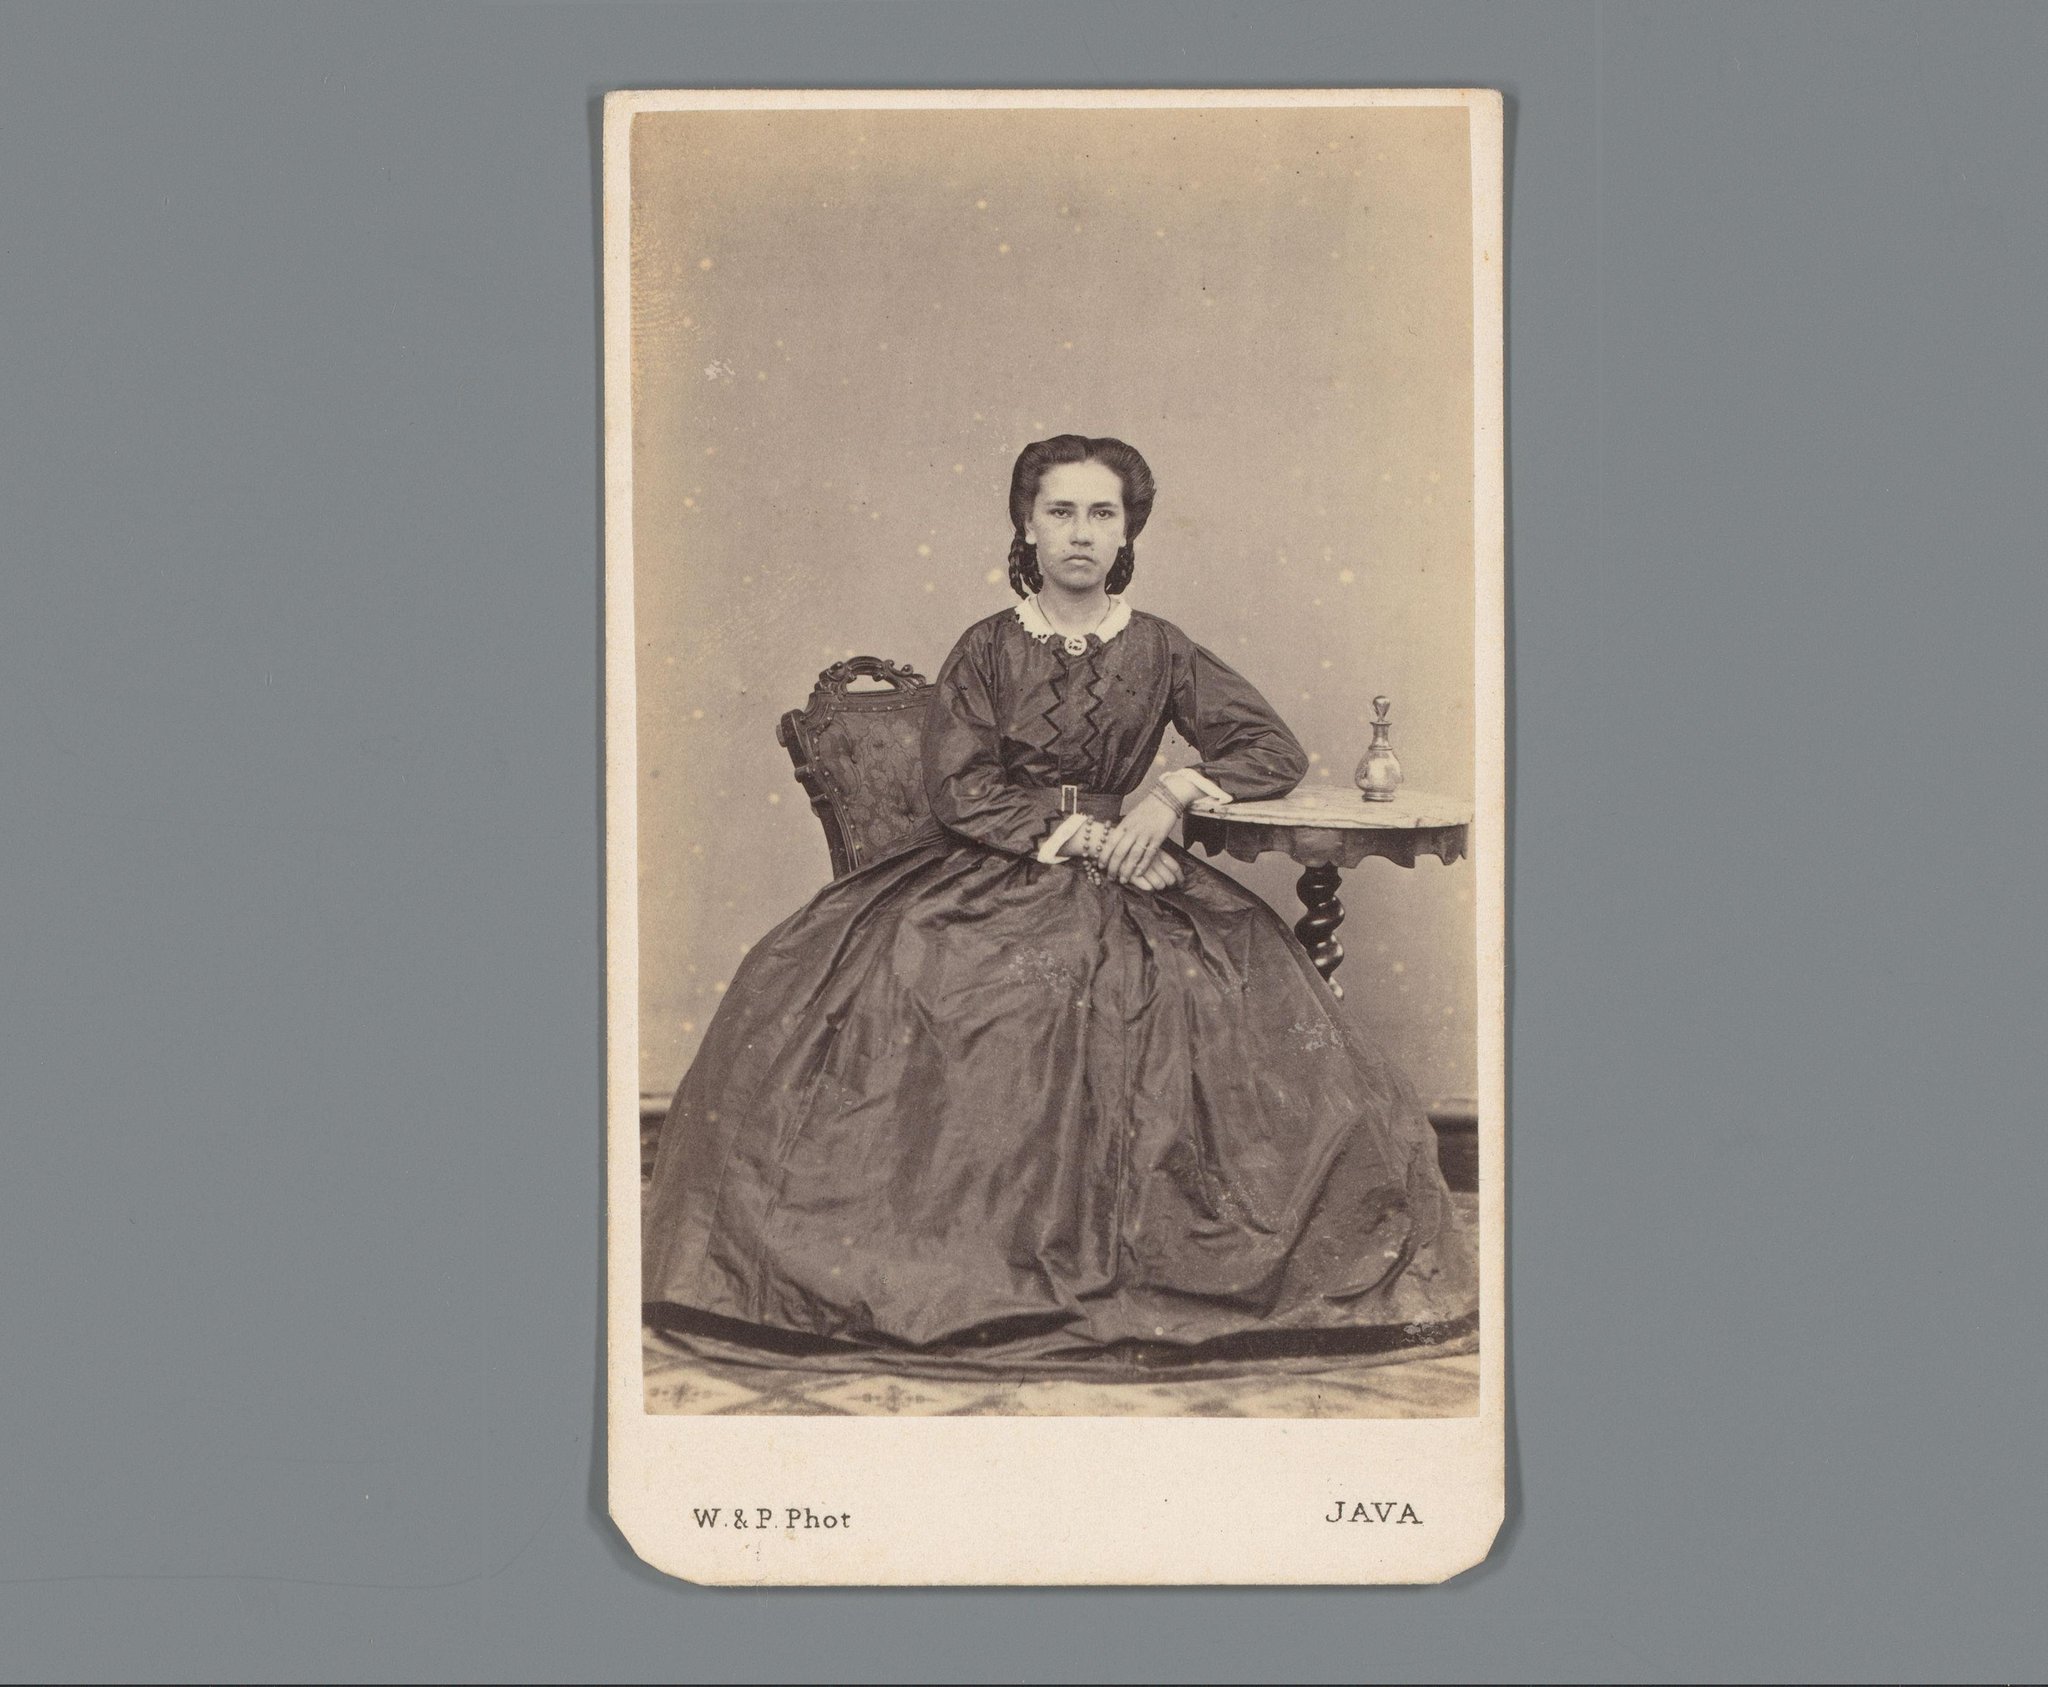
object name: carte de visite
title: Portret van een zittende vrouw 'Albertina'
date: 1855-1899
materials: cardboard, photographic support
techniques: albumen print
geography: java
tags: anonymous historical person portrayed - bb - woman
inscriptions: inscription: ‘No. 3 7472 Albertina 12 copies’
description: Portret van een zittende vrouw 'Albertina'. Mogelijk een lid van de familie Swellengrebel.